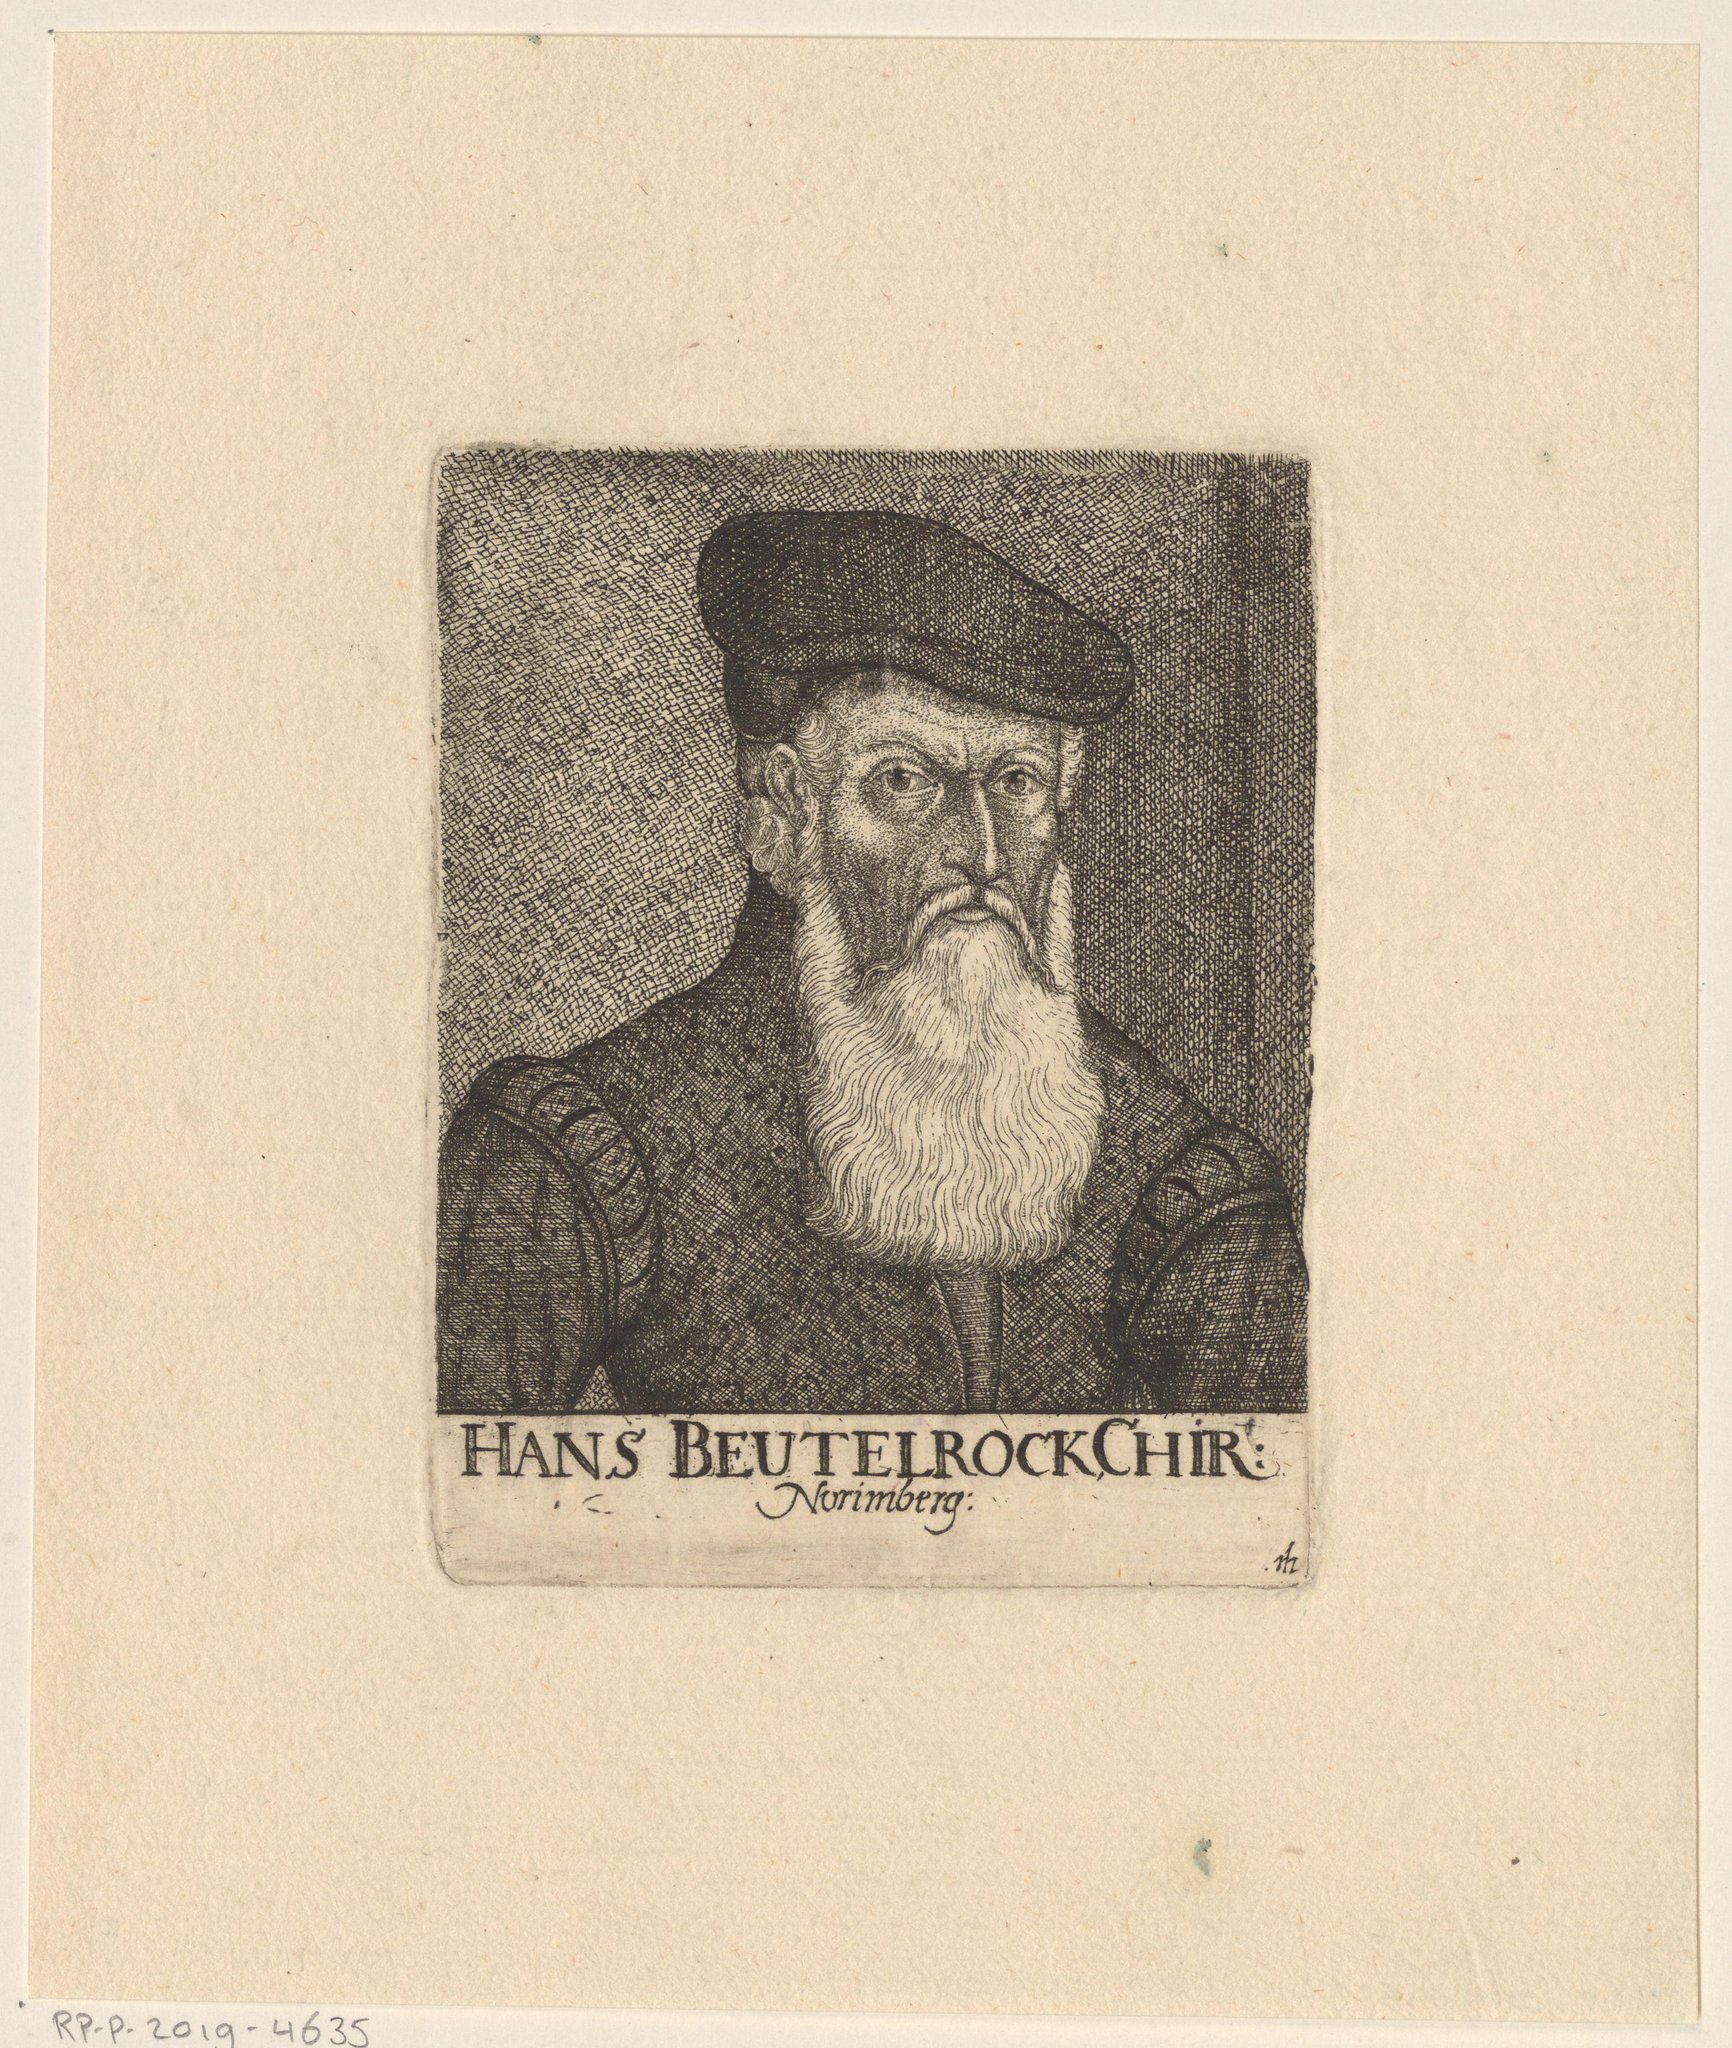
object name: print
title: Portret van Hans Beutelrock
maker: johann reinhold mühl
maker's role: print maker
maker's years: 1631-1692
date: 1642-1692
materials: paper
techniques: etching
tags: historical persons